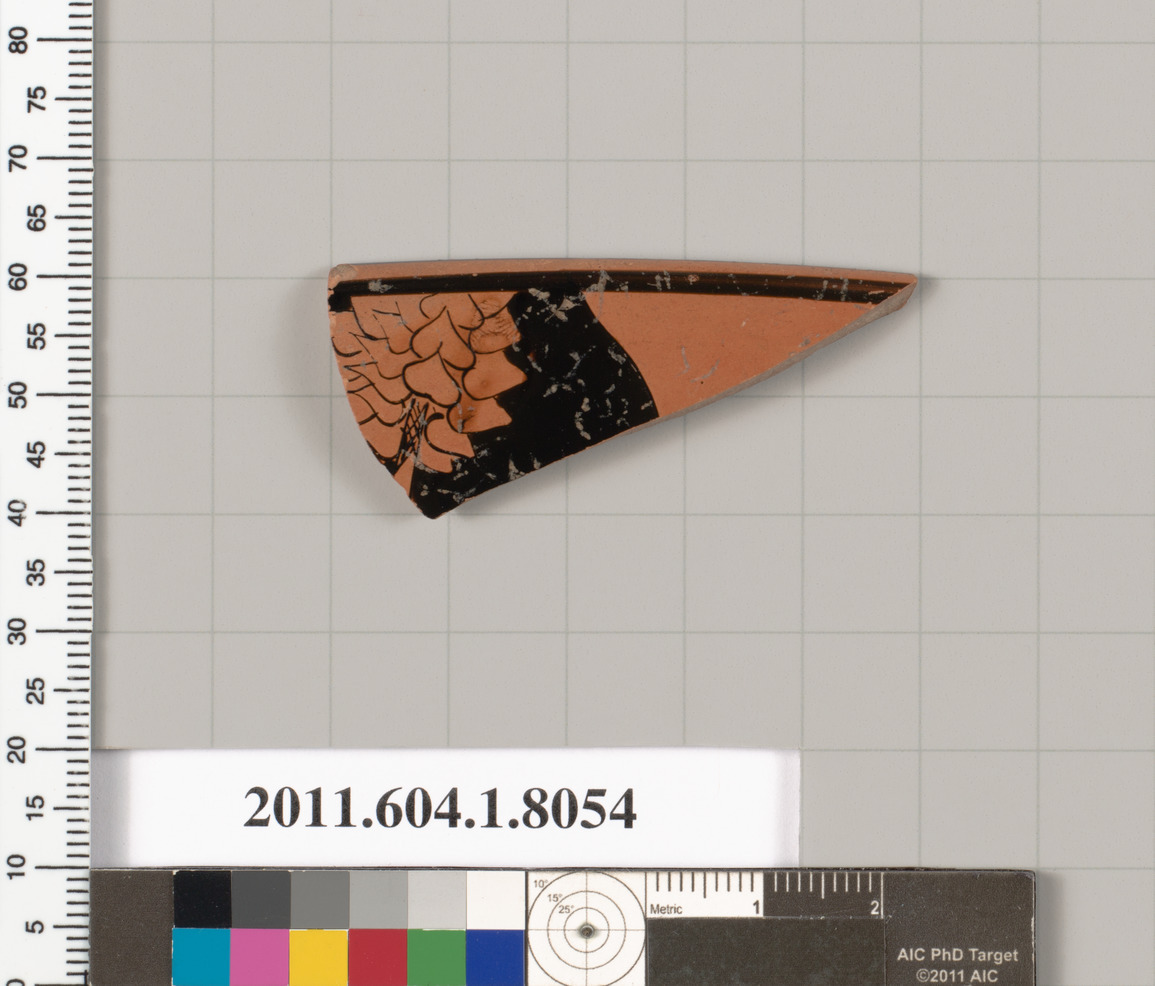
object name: kylix fragment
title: Terracotta rim fragment of a kylix (drinking cup)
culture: greek, attic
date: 510-500 BCE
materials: terracotta